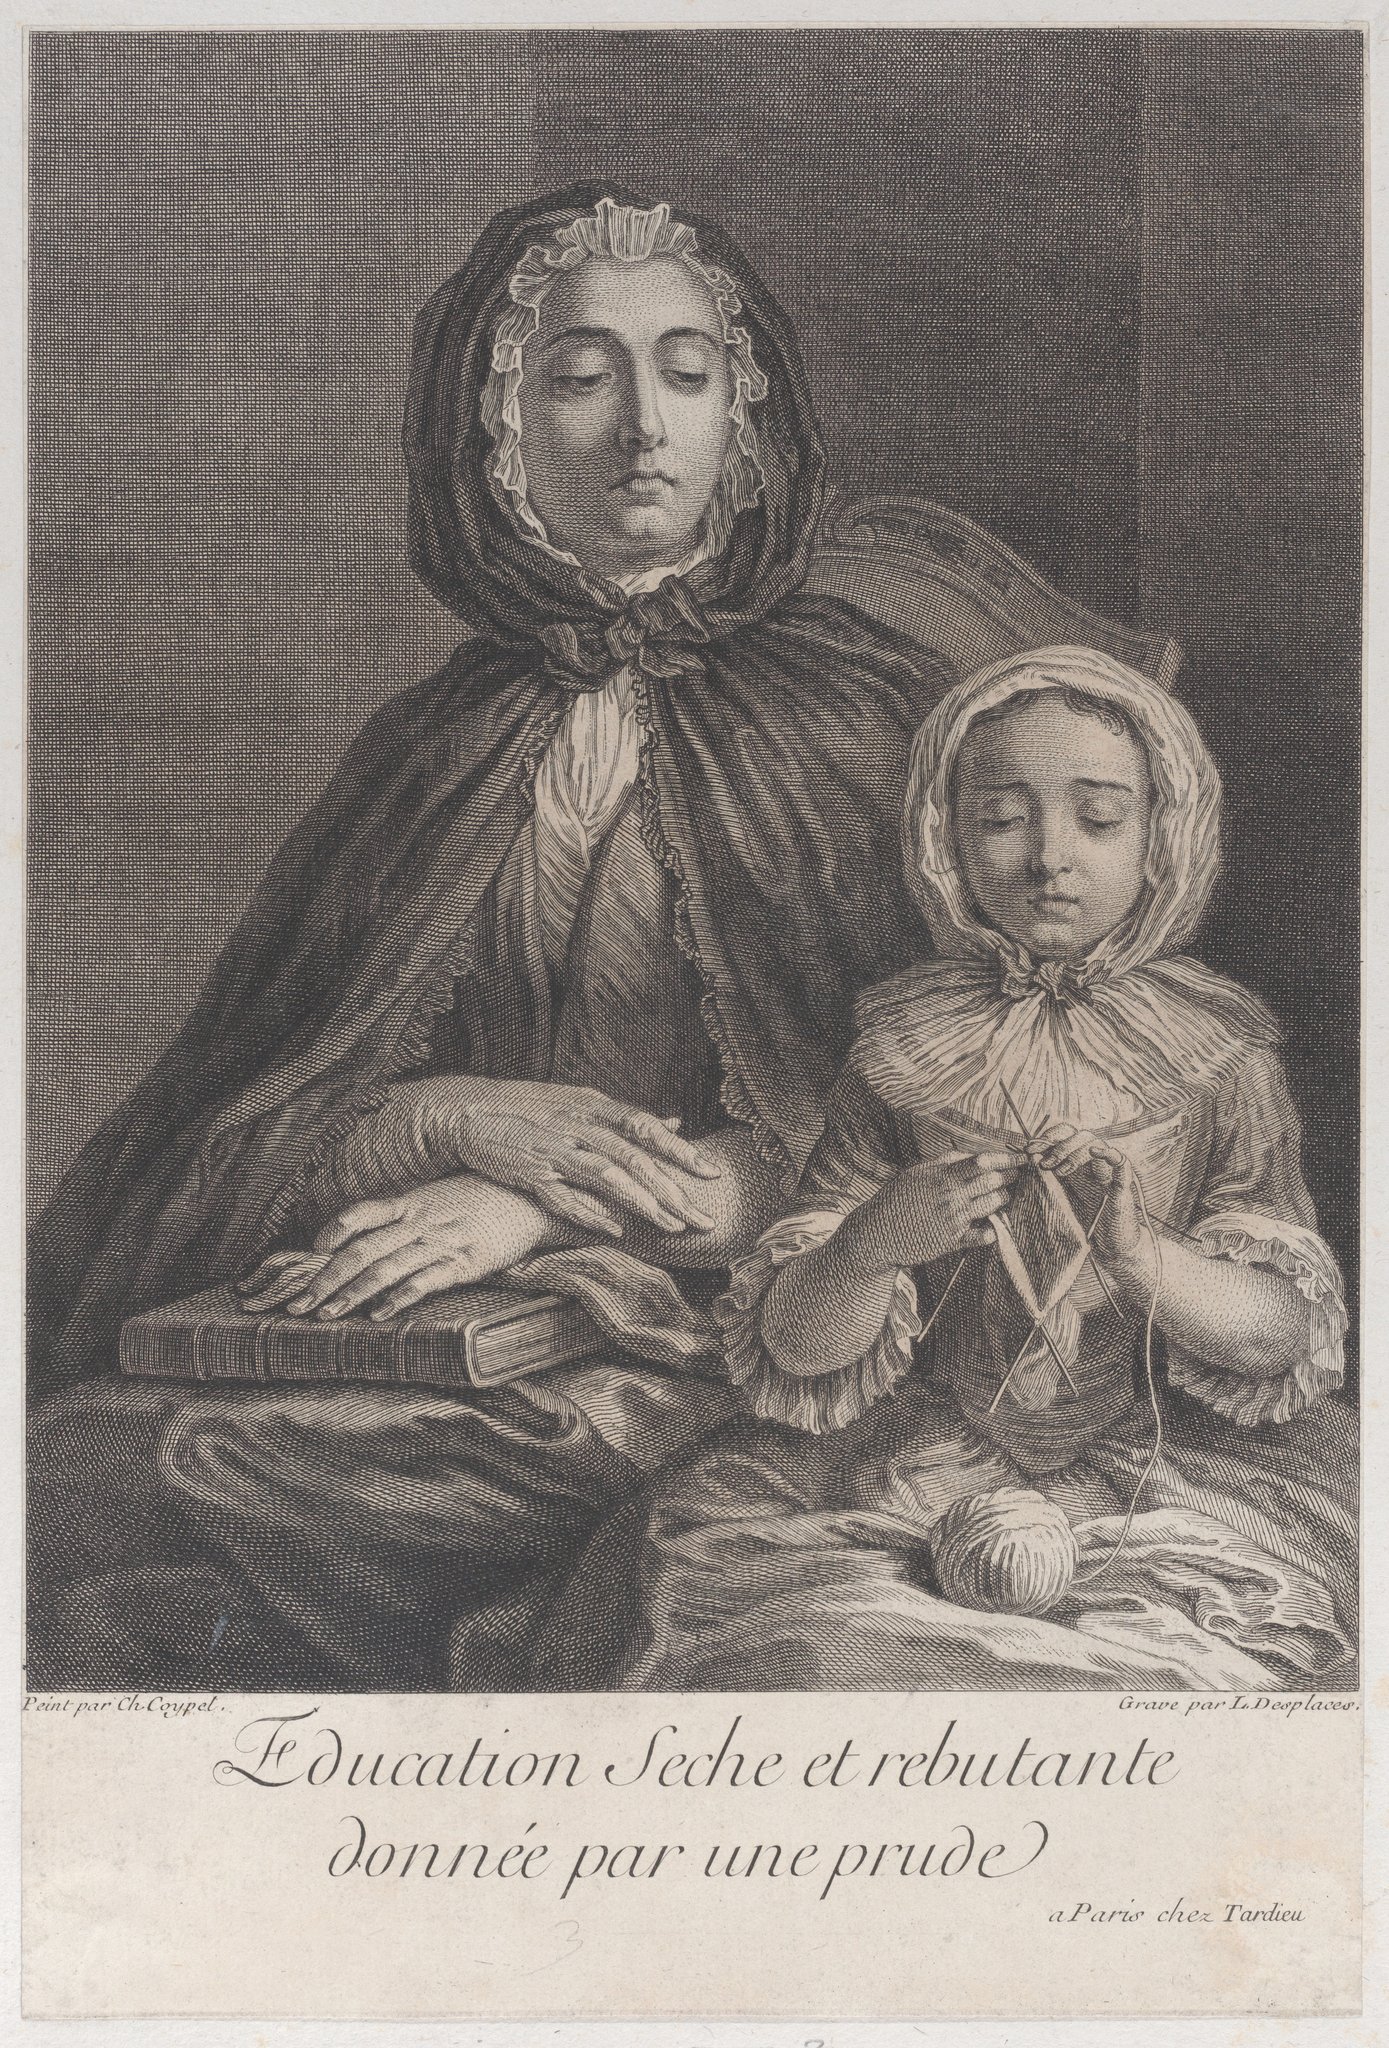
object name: print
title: The dry and forbidding education given by a prude (Education seche et rebutante donnée par un prude)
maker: louis desplaces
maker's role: artist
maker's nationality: french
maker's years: 1682-1739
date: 1700-1739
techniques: engraving, etching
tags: girls,women,knitting